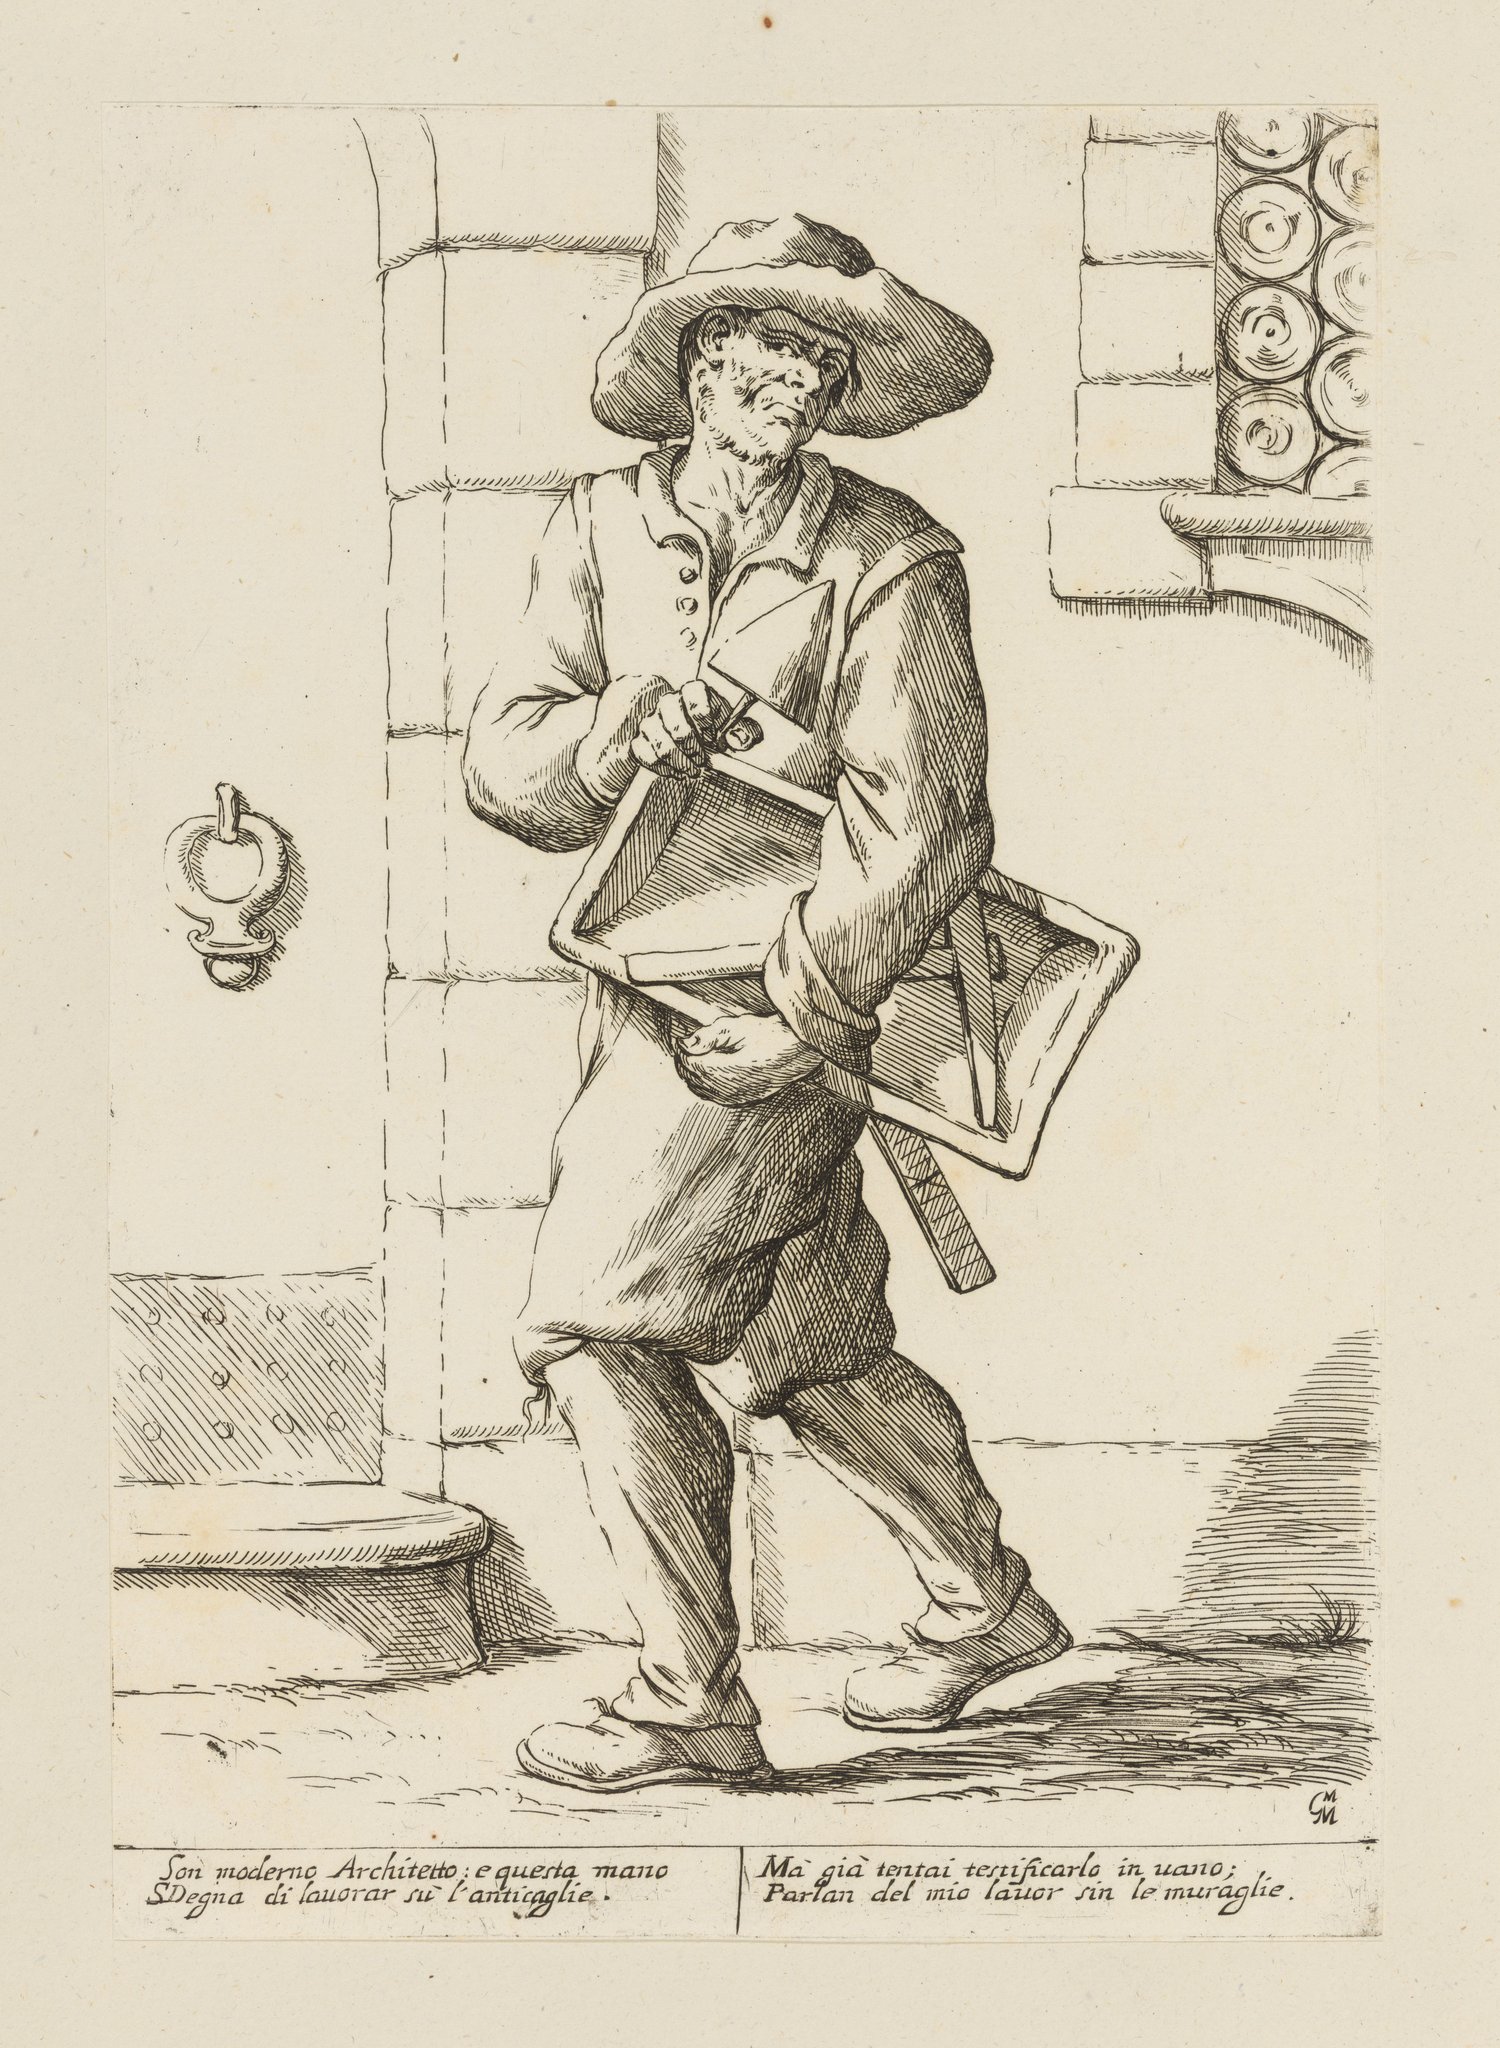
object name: print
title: Mason, from Di Bologna l'Arti per via D'An.ibal' Ca.rac, plate 10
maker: giuseppe maria mitelli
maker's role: artist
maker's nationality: italian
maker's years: 1634-1718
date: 1660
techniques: etching